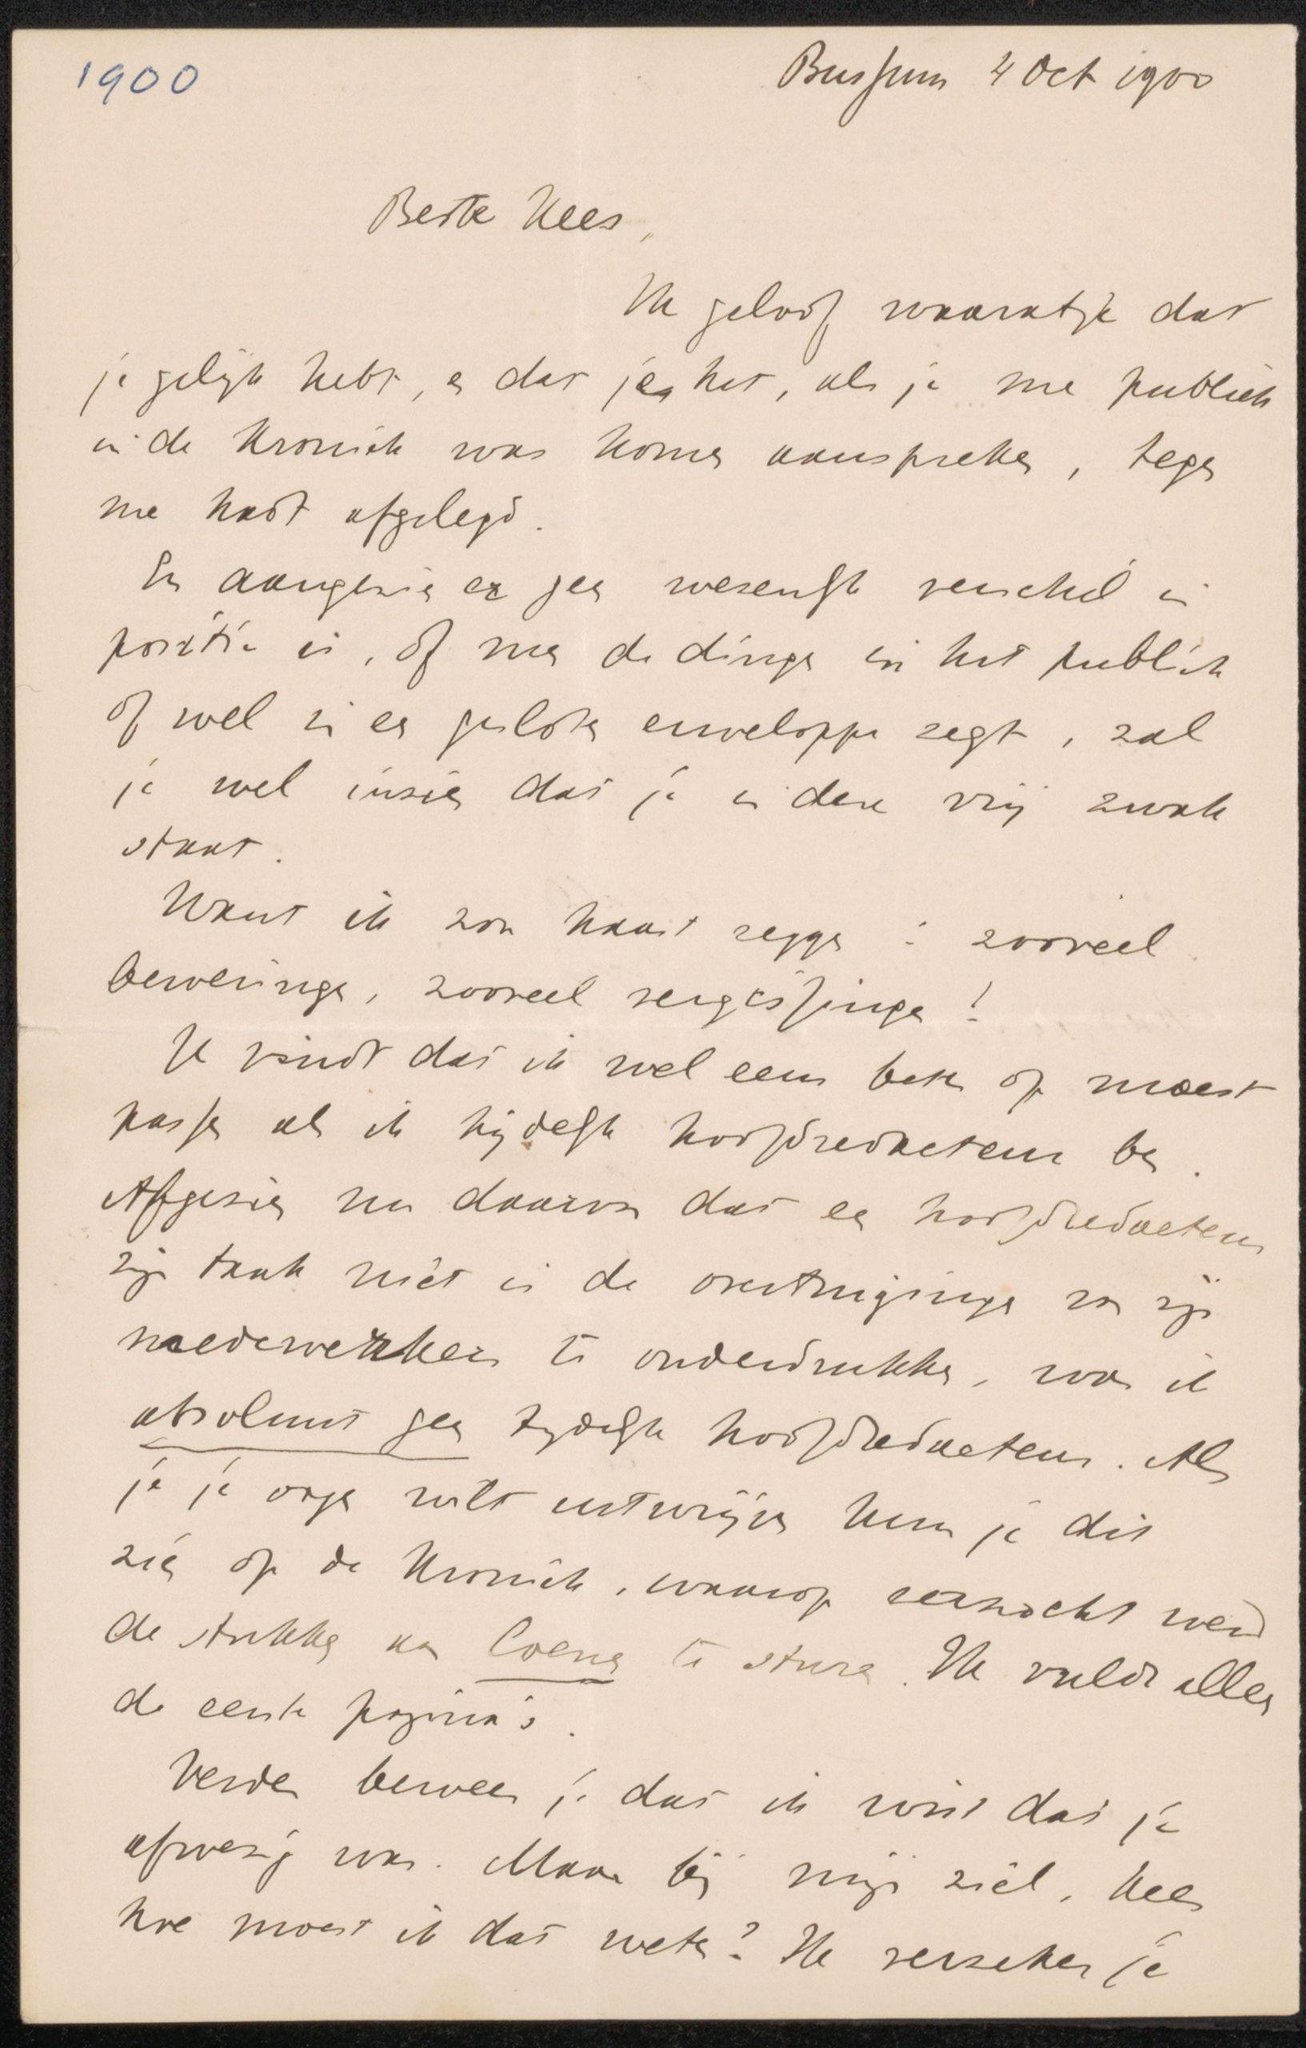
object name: letter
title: Brief aan Cornelis Gerardus 't Hooft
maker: jan veth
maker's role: designer, draughtsman, painter, print maker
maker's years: 1864-1925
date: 1900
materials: ink, paper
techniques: pen, writing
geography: bussum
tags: painter, print maker, draughtsman, johannes bosboom, cornelis gerardus 't hooft, criticizing and discussing art, art criticism, exhibition ~ art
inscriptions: collector's mark: ‘RPK’